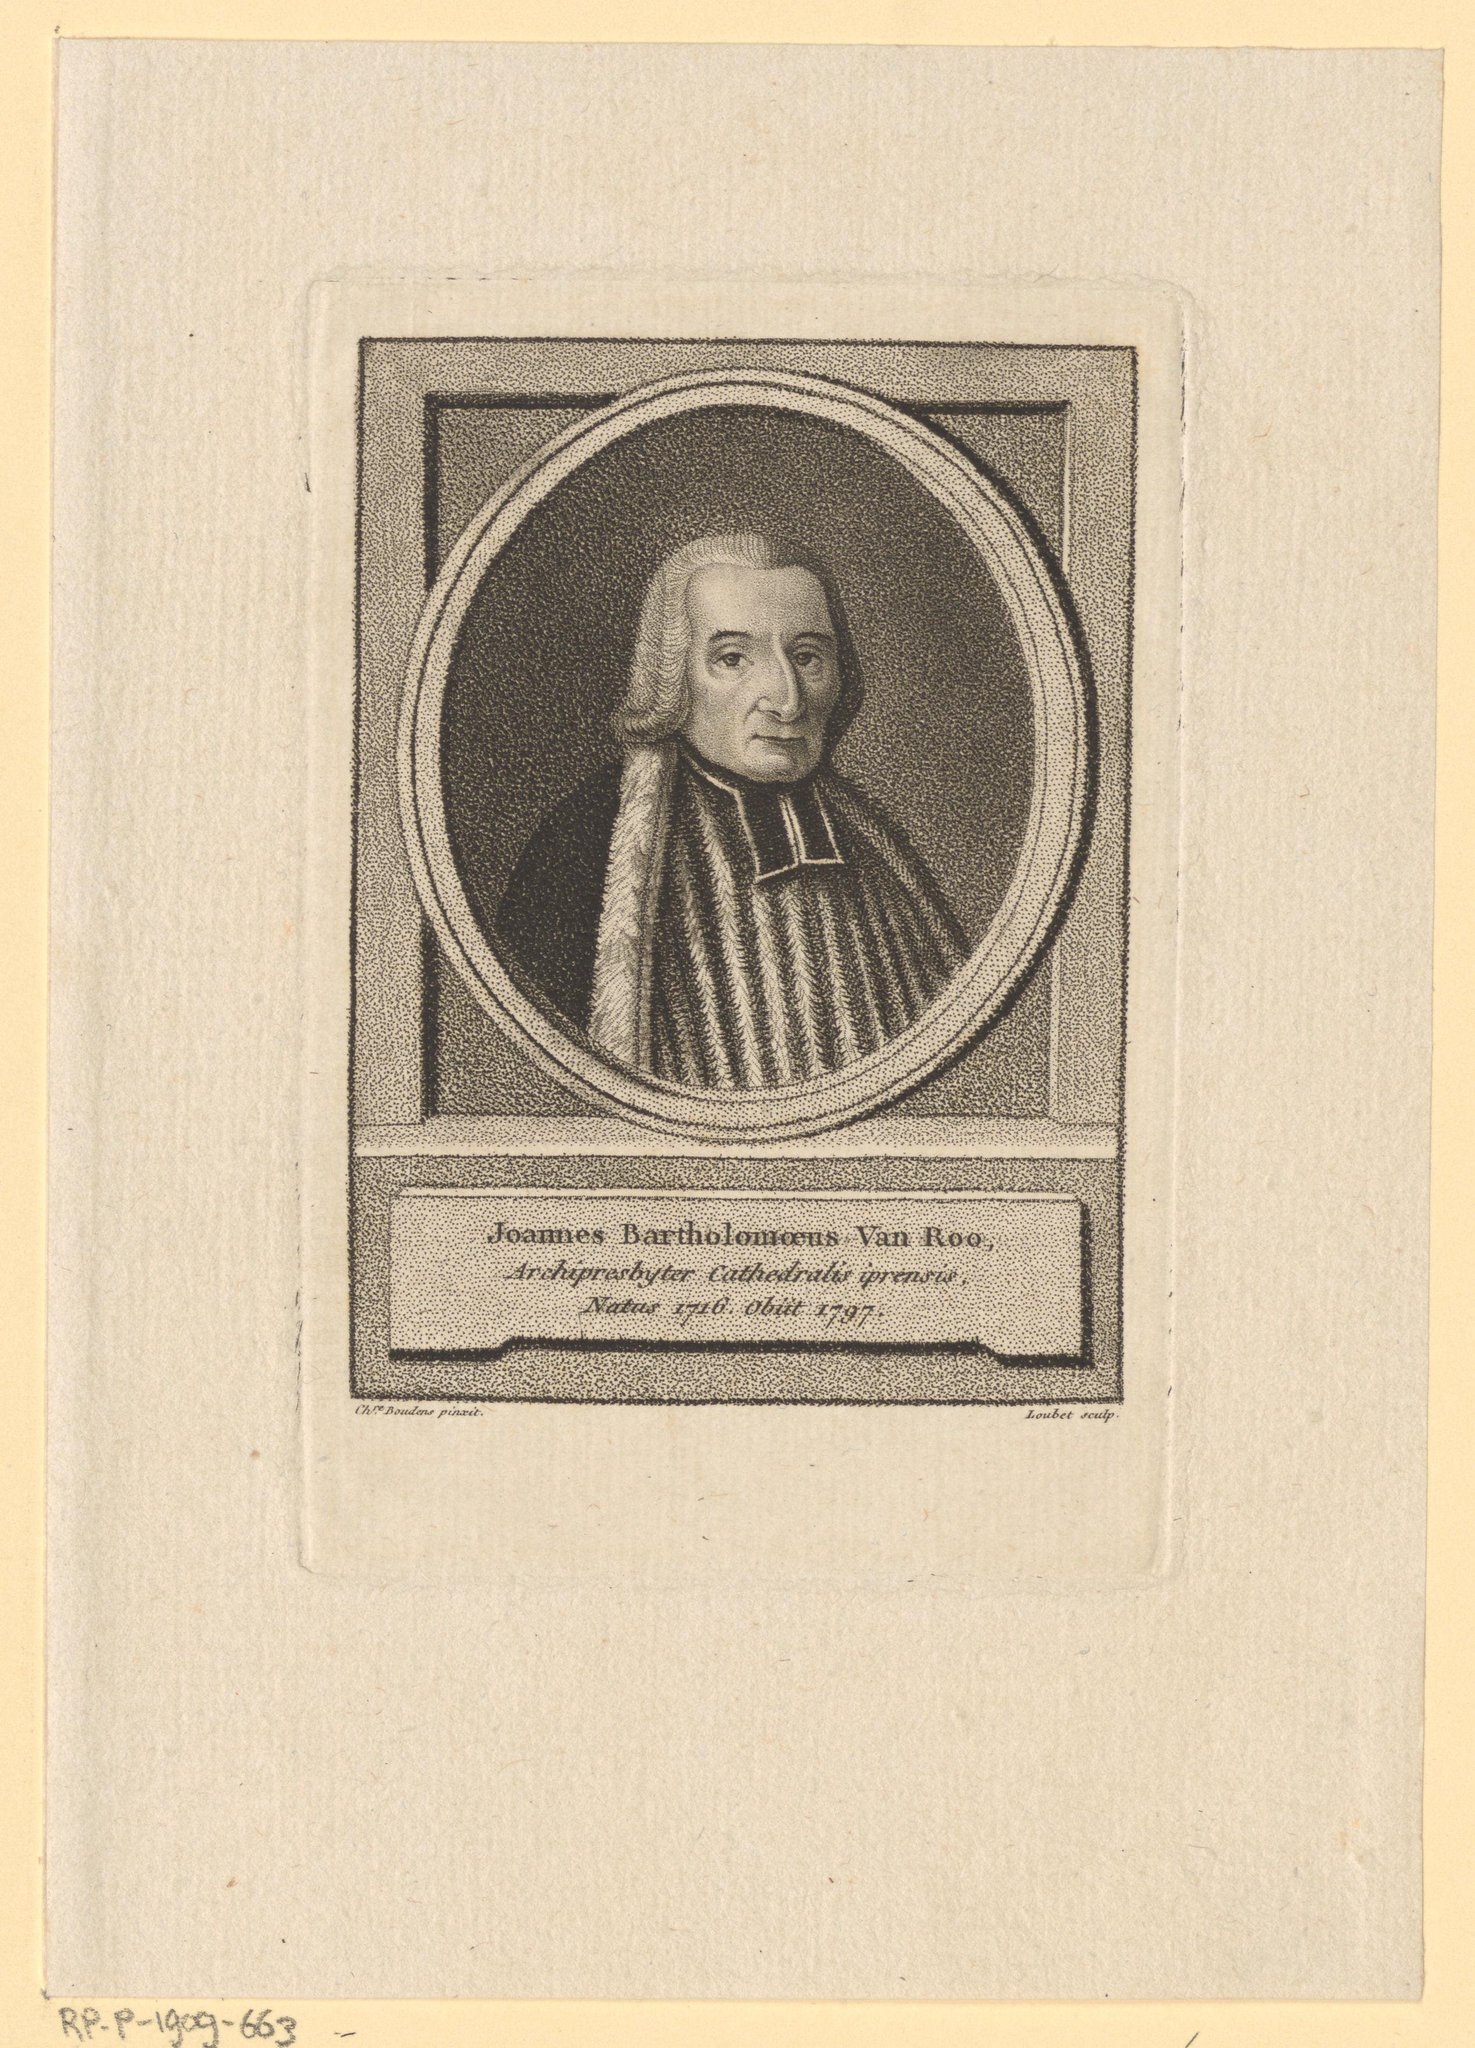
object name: print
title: Portret van Joannes Bartholomoeus de Roo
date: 1797-1899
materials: paper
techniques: engraving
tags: historical persons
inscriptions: collector's mark: Lugt 2228